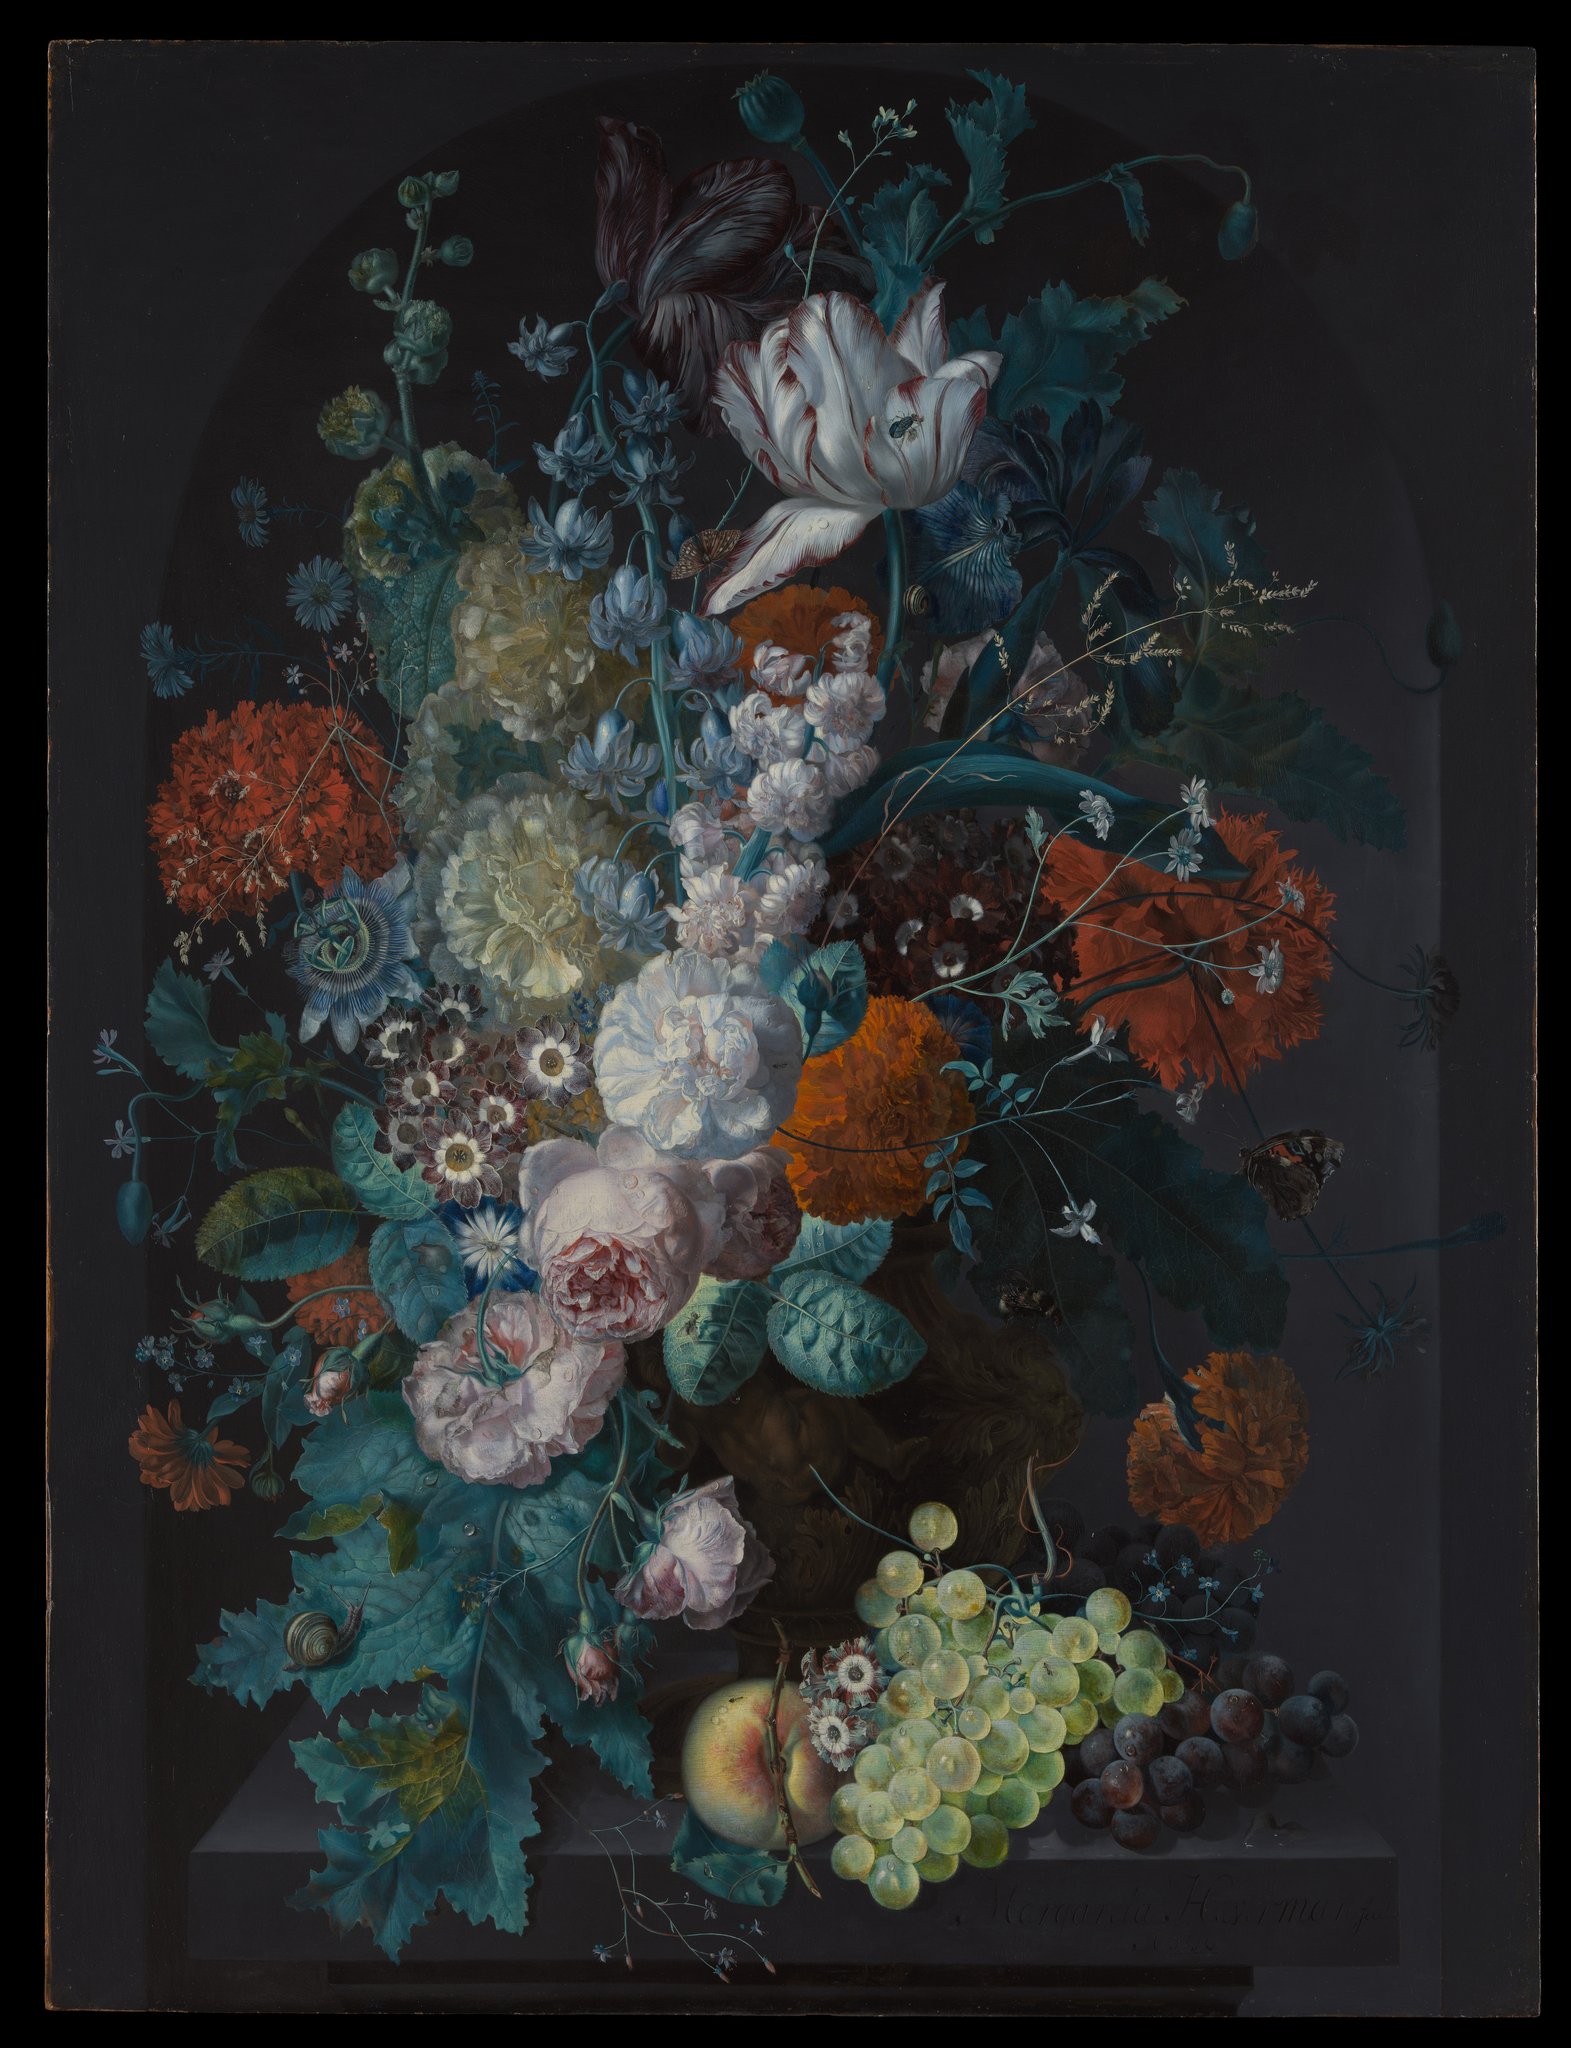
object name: painting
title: A Vase of Flowers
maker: margareta haverman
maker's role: artist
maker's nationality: dutch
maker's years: 1693-1722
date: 1716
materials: oil, wood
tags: grapes,flowers,still life